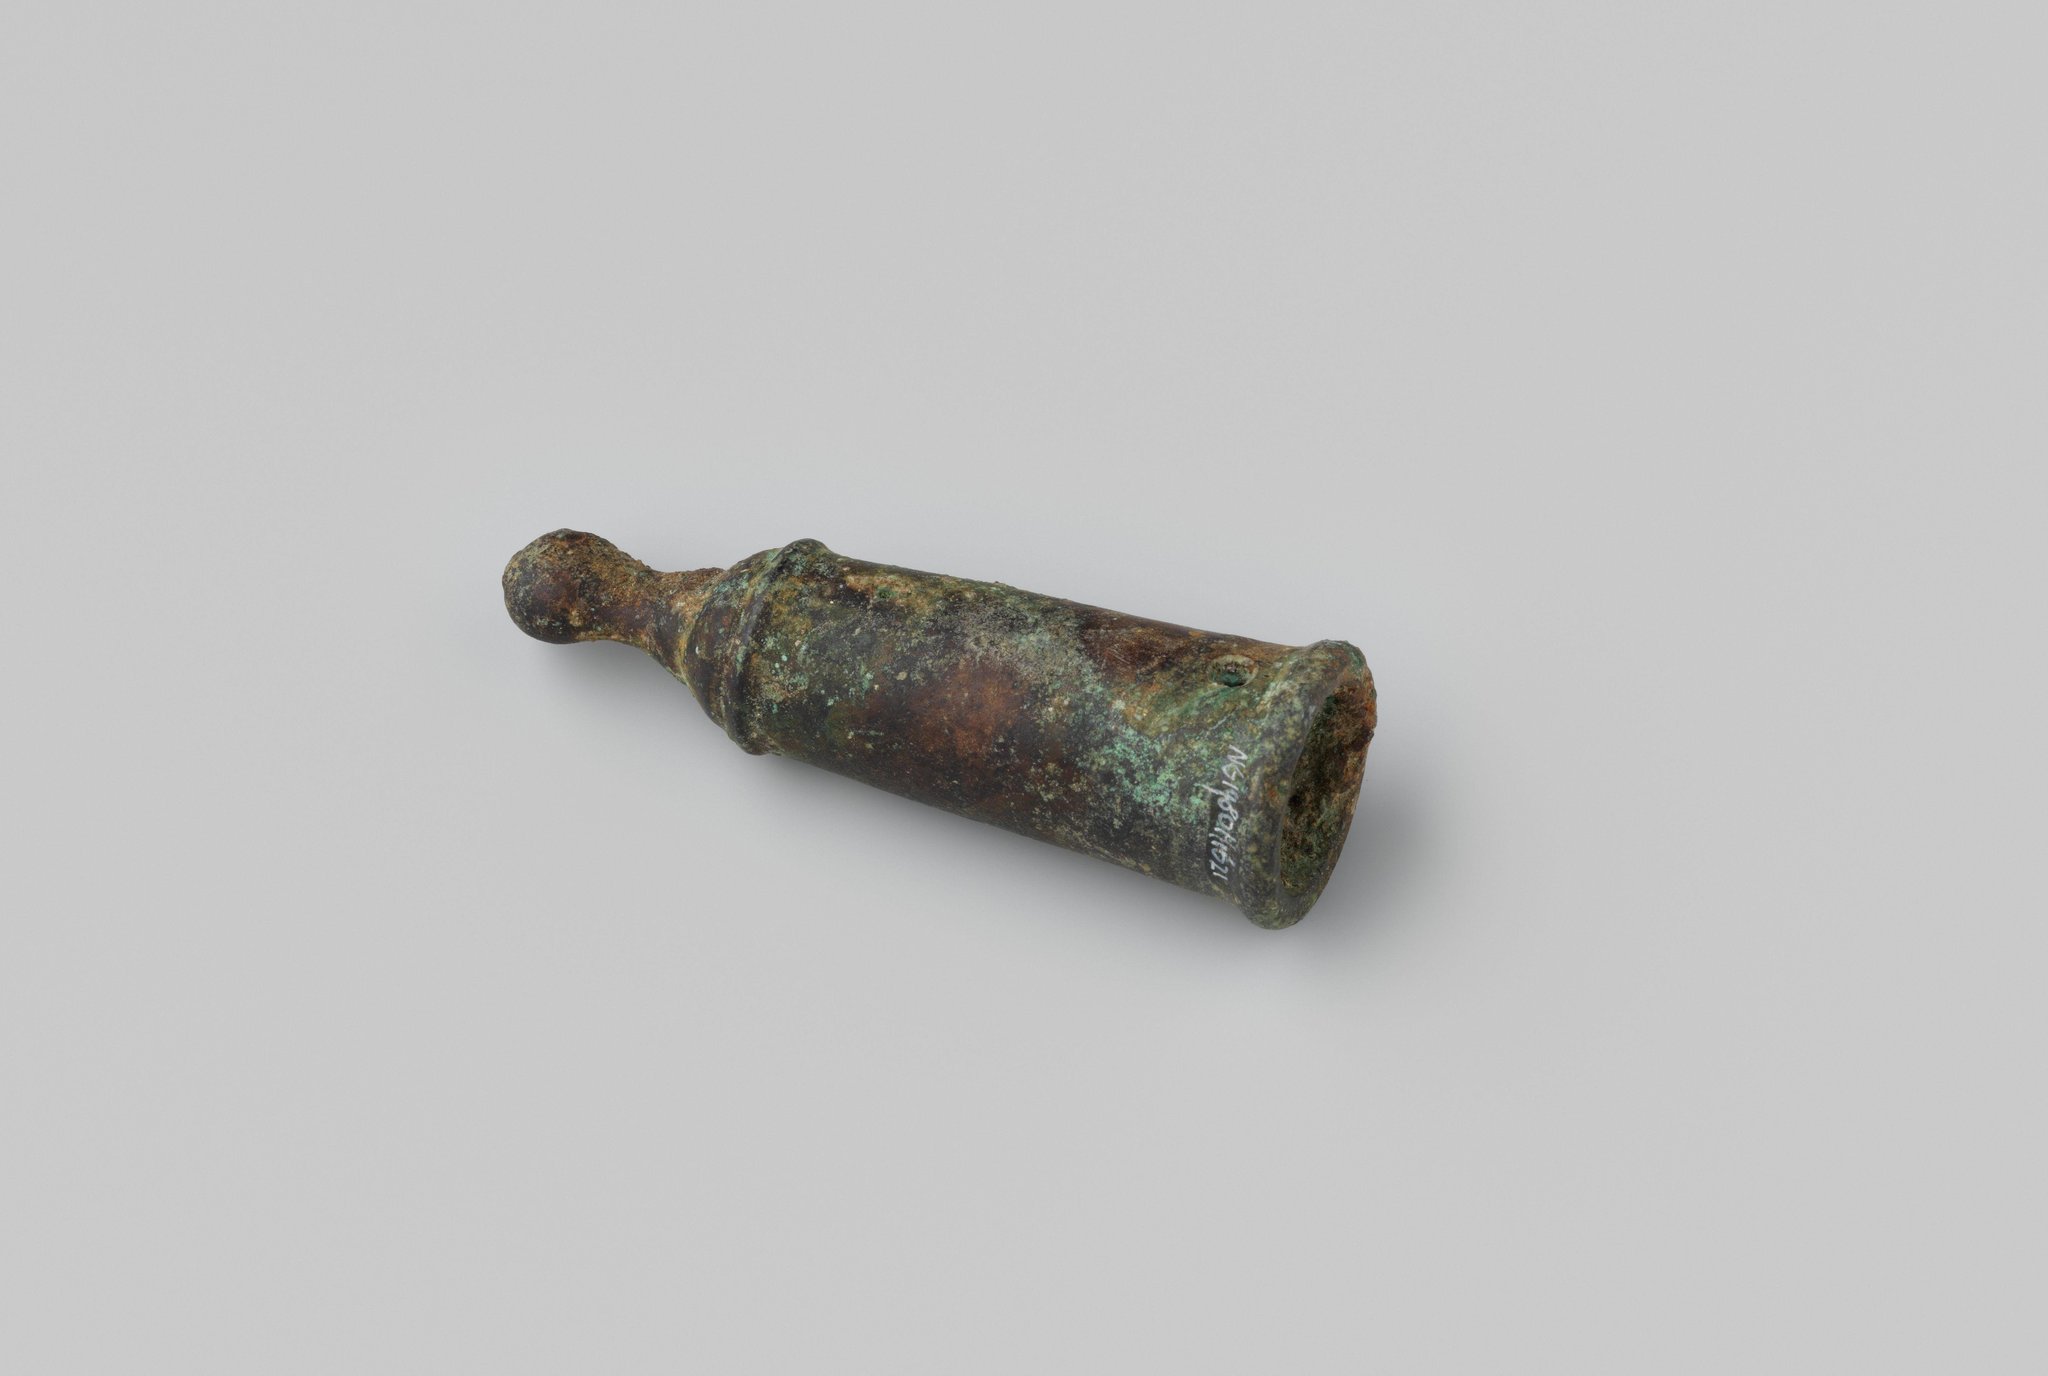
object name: clamp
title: Klem afkomstig uit het wrak van de Oost-Indiëvaarder Hollandia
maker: Anonymous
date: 1700-1743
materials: copper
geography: netherlands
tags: verenigde oostindische compagnie, hollandia (schip)